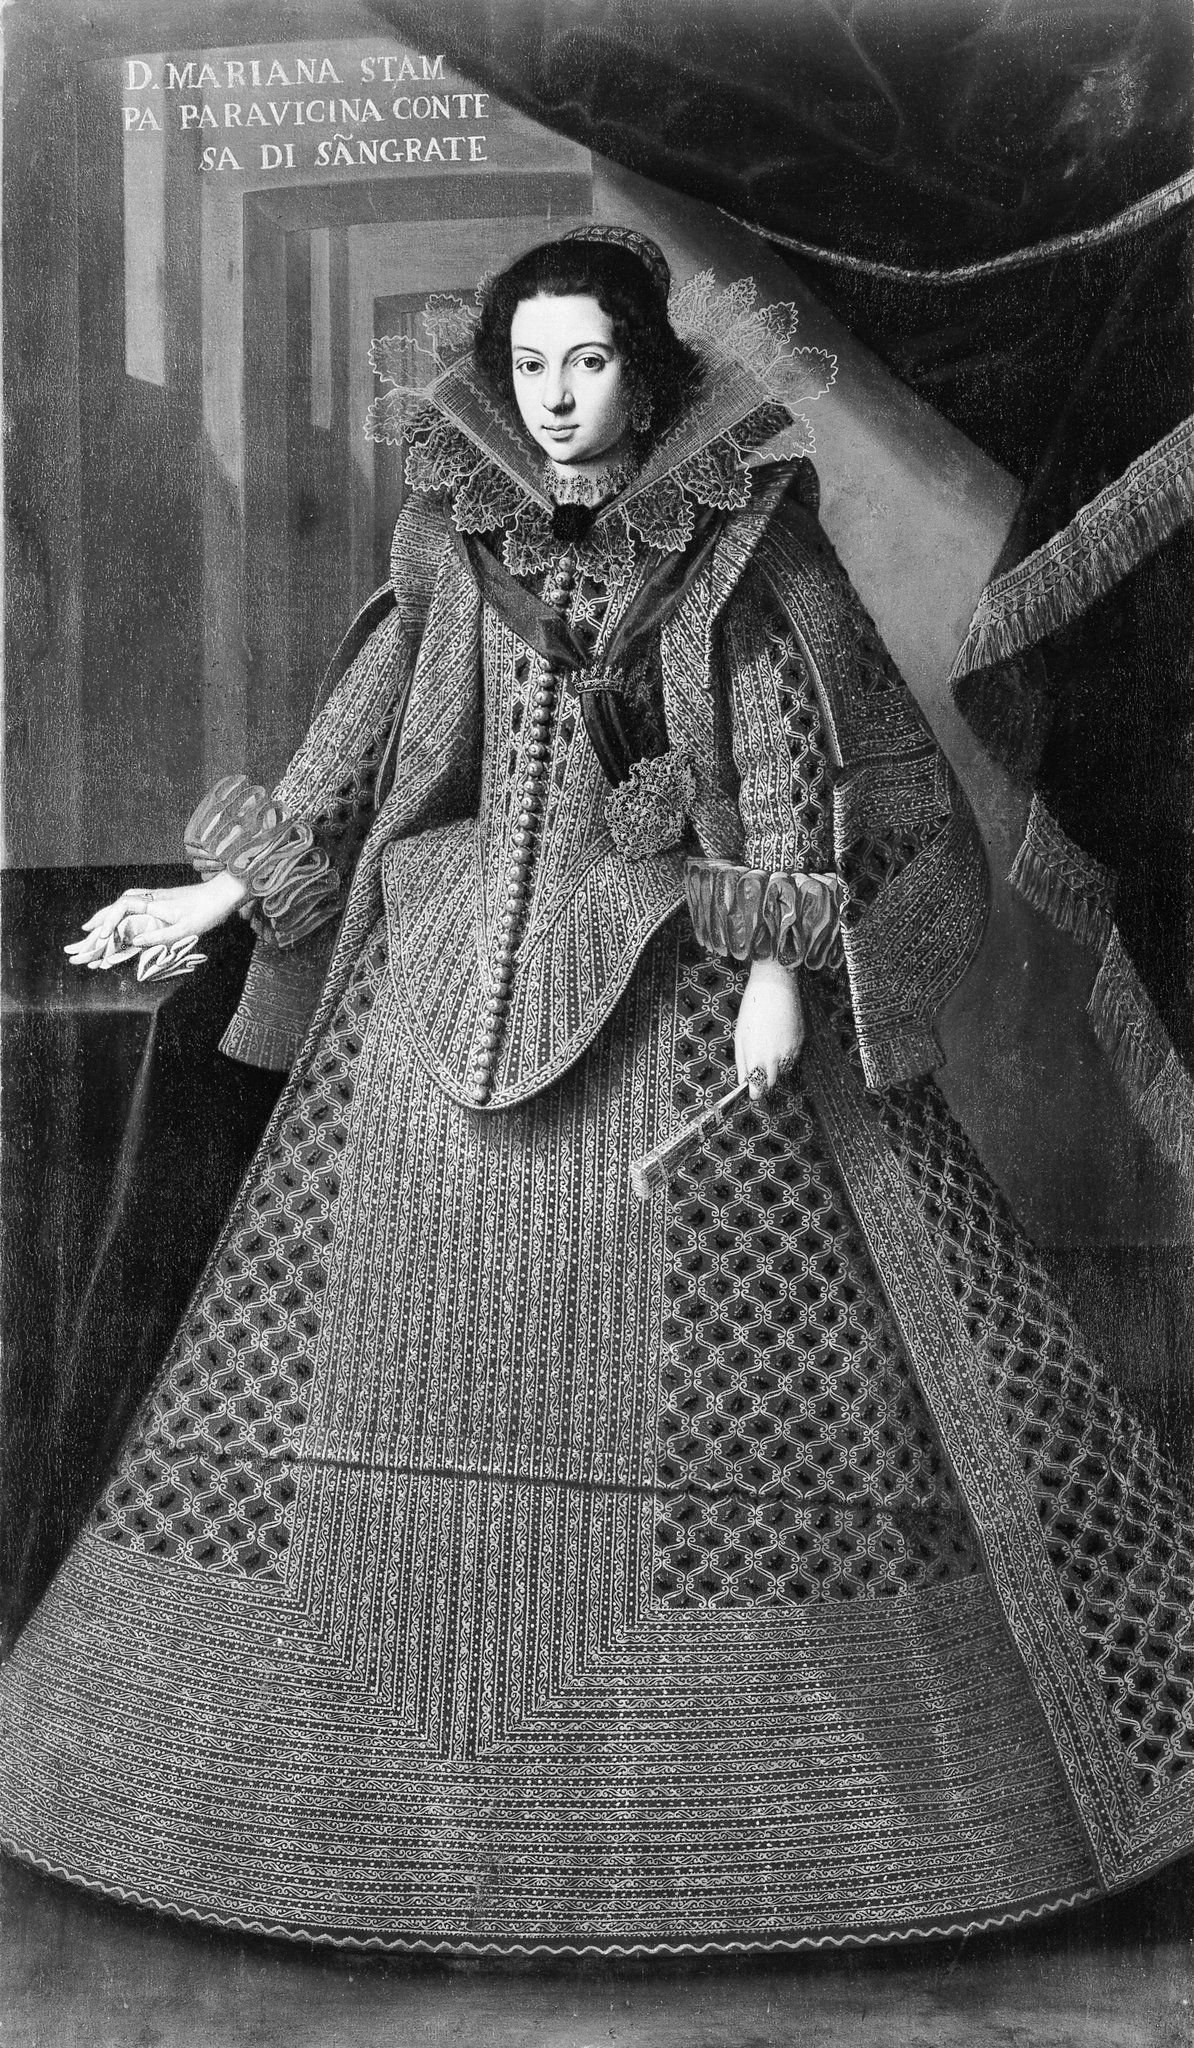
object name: painting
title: Doña Marianna Stampa Parravicina (born 1612), Condesa di Segrate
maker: spanish painter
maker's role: artist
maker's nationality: spanish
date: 1600-1629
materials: canvas, oil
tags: portraits,women